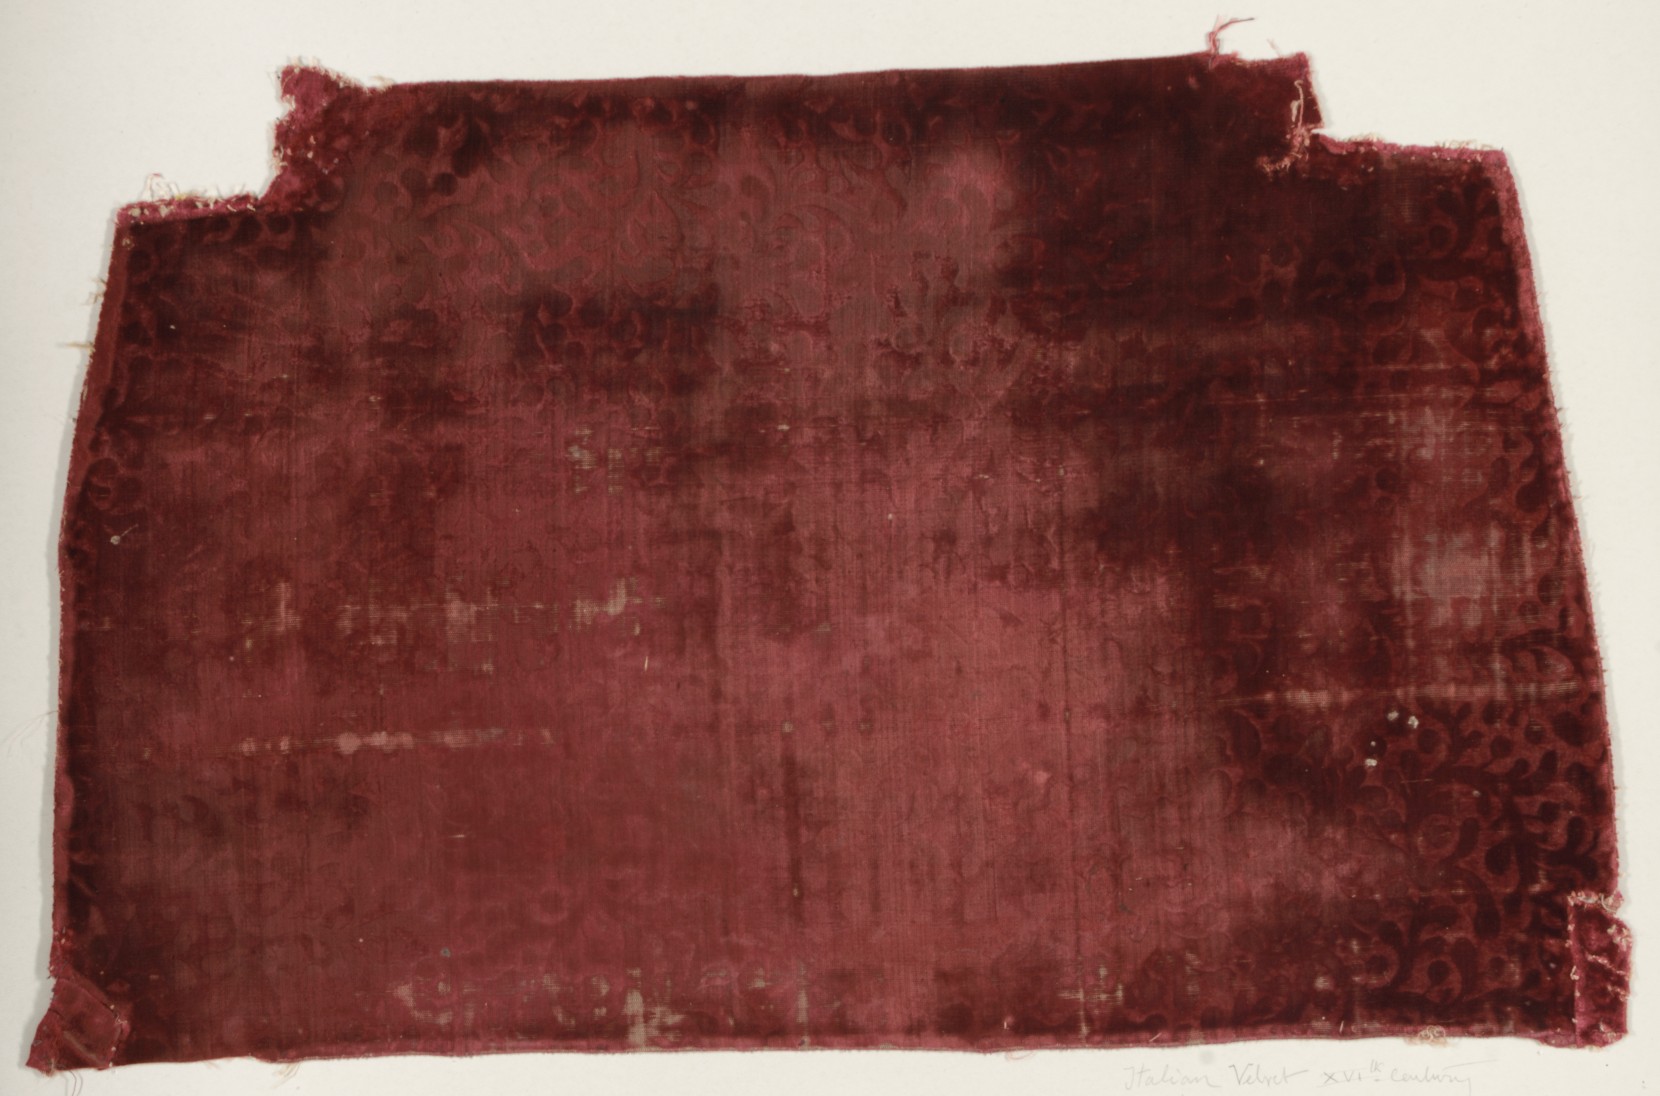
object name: fragment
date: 1501-1600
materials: silk